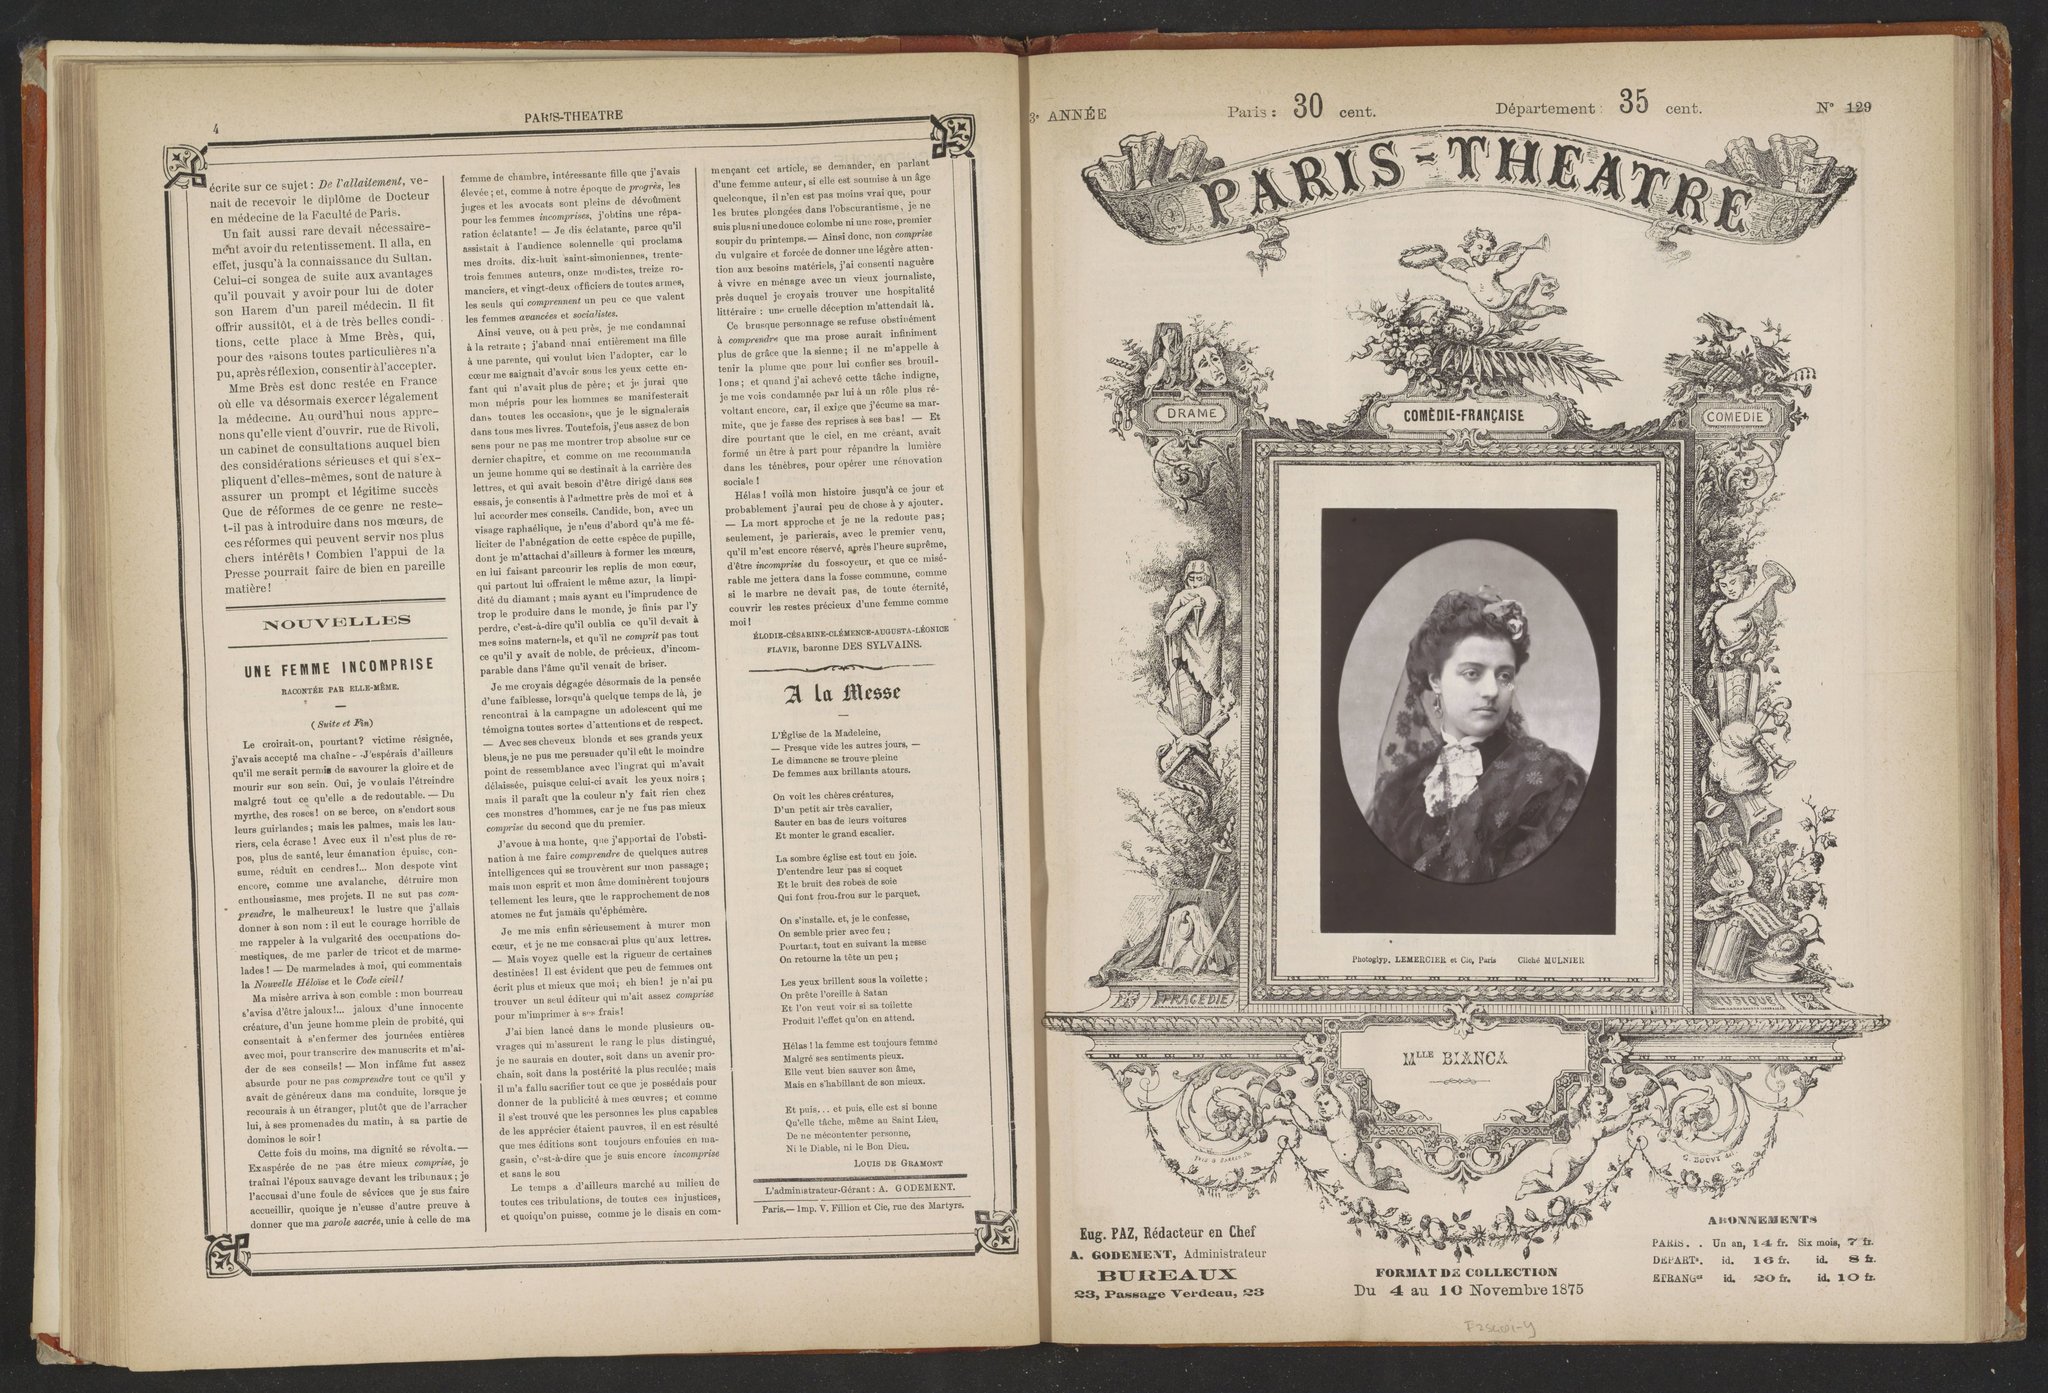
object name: photomechanical print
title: Mlle Bianca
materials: paper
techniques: woodburytype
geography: france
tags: portrait of actor, actress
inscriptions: number: ‘No 129’, inscription: ‘Du 4 au 10 Novembre 1875’